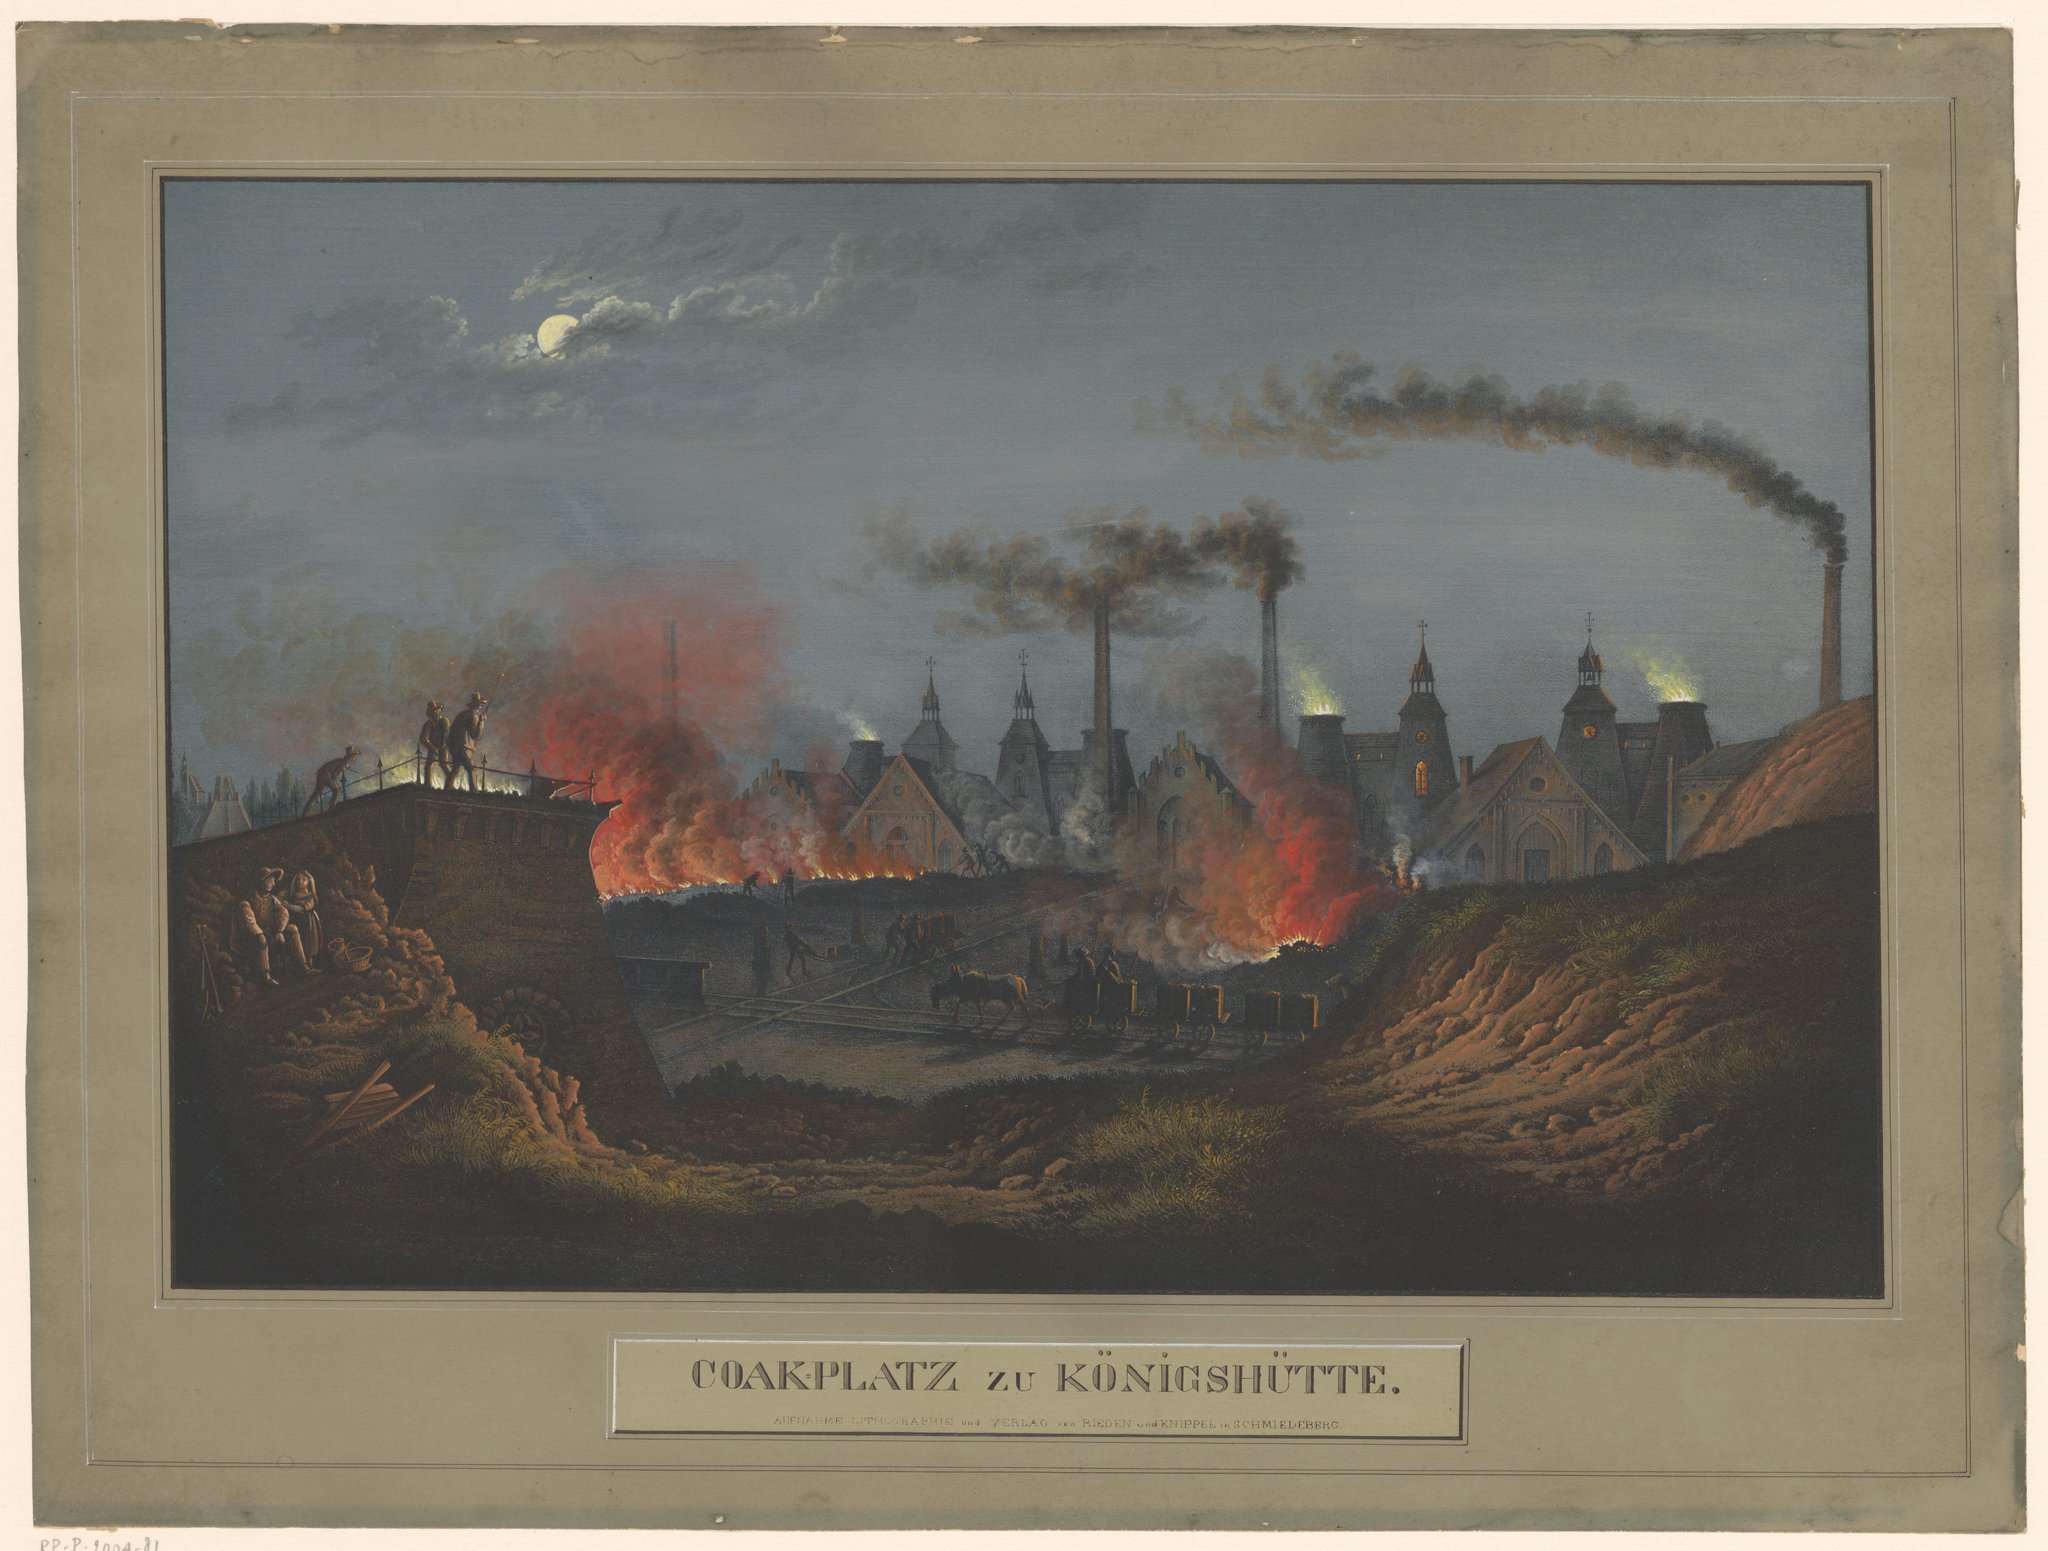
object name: print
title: Kolenfabrieken te Königshütte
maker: Anonymous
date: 1840-1860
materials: paper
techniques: hand coloring, lithograph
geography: schmiedeberg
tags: smoke-stack, factory-building, crafts and industries (+ men (labourers))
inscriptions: collector's mark: Lugt 2228